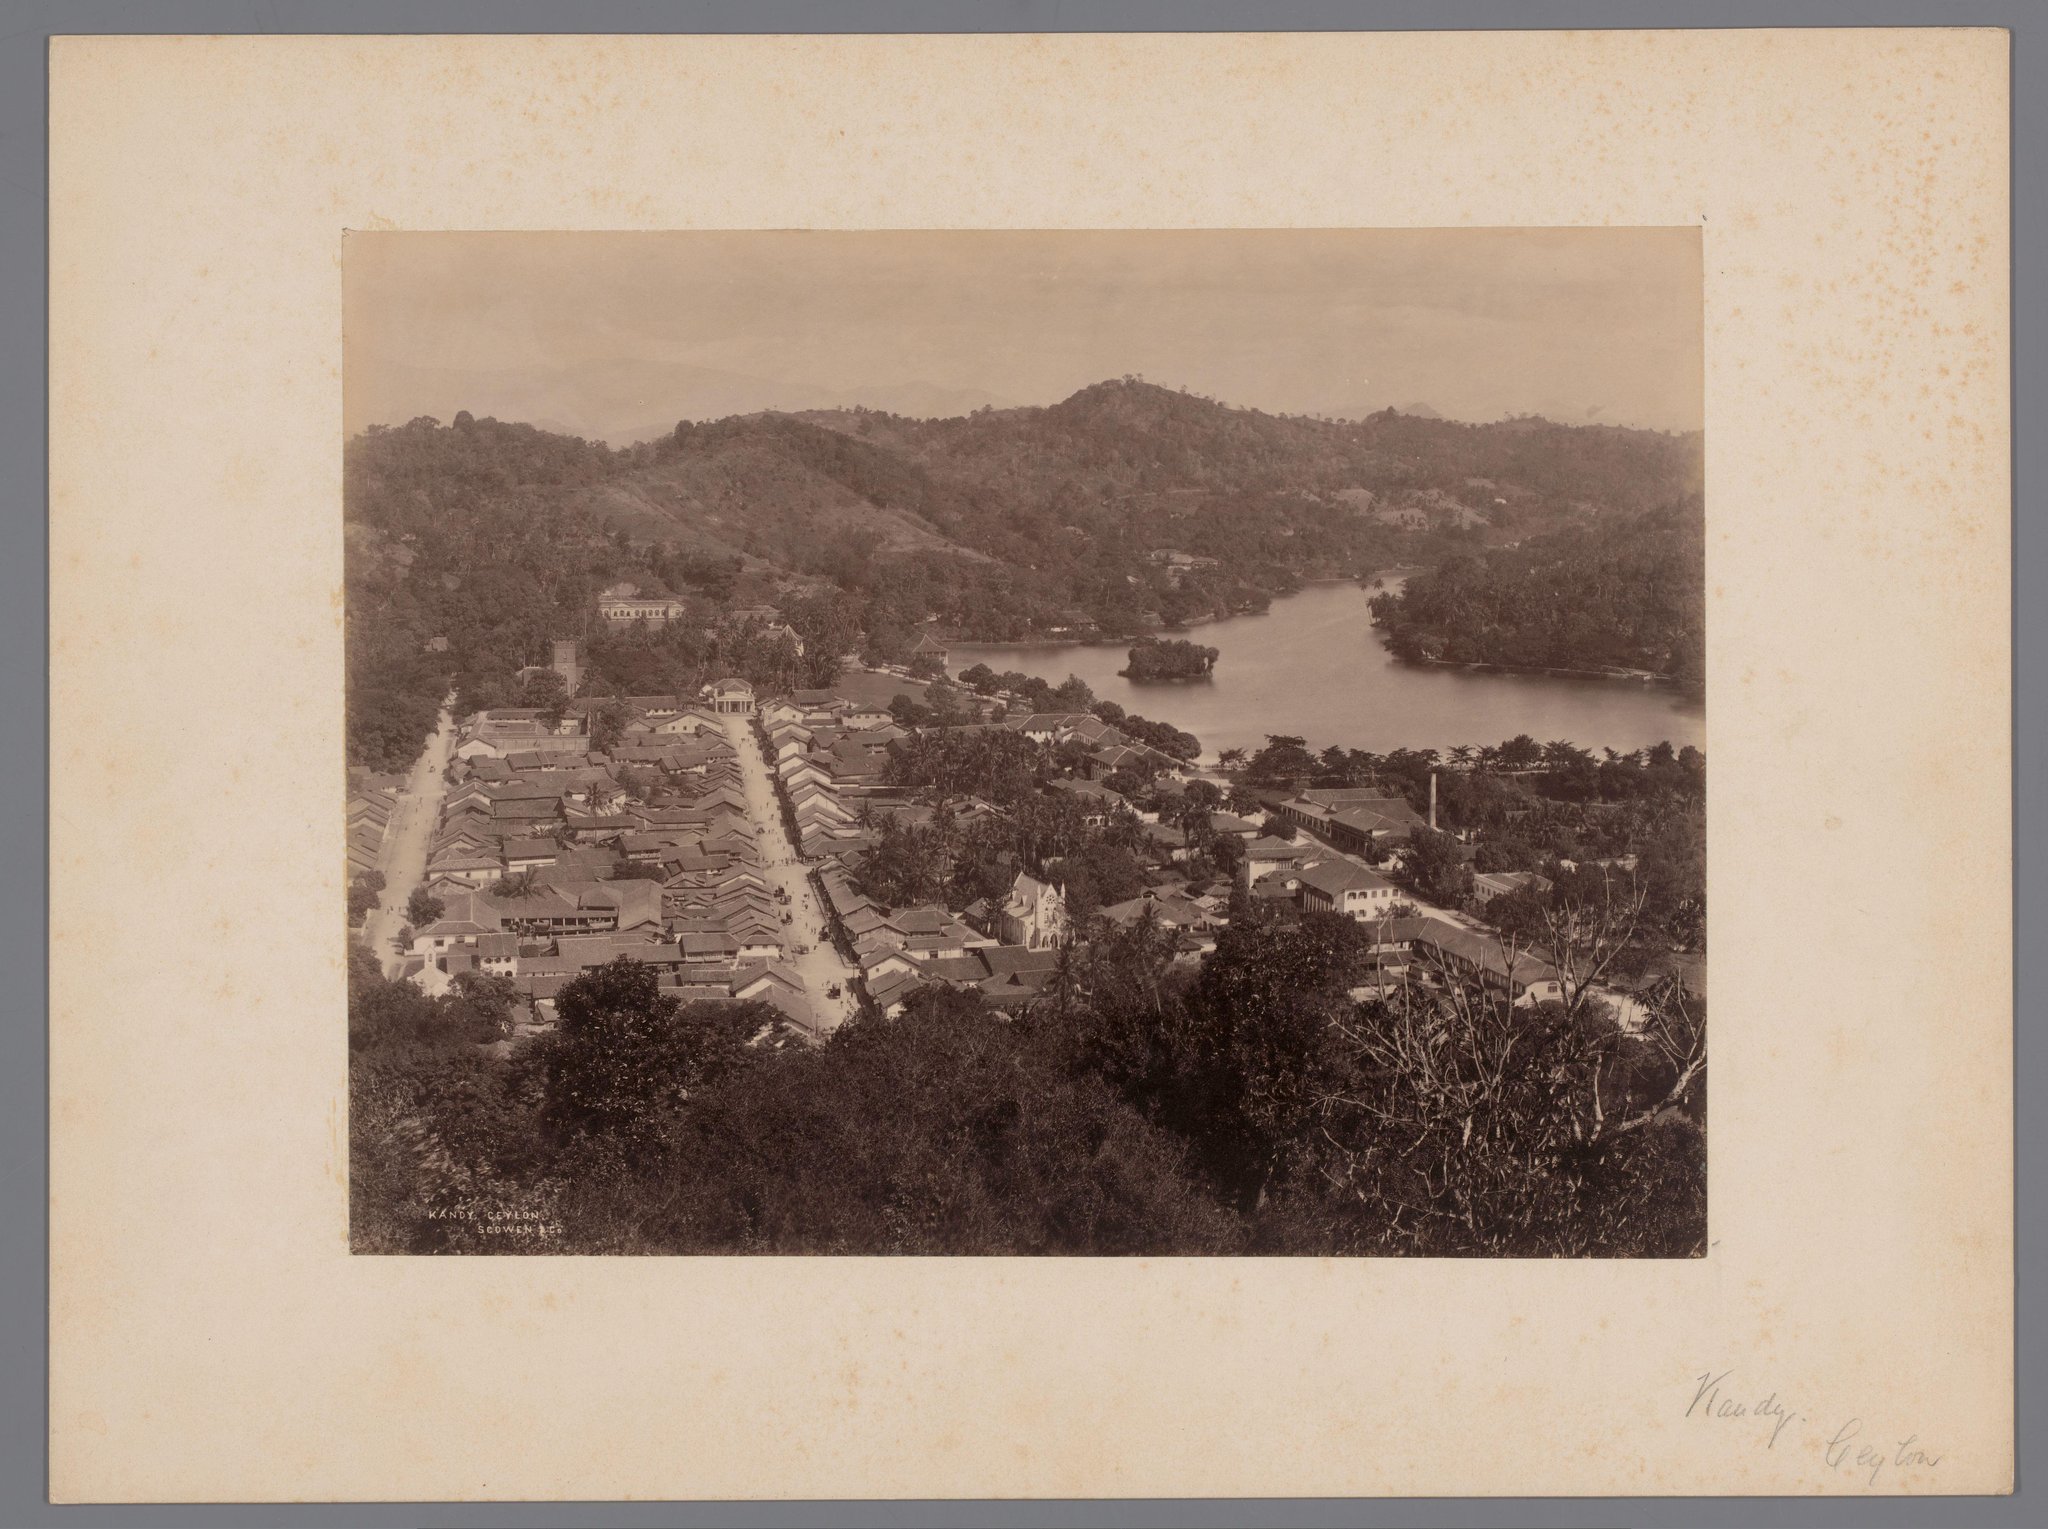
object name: photograph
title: View of Kandy, Sri Lanka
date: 1870-1890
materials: cardboard, paper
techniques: albumen print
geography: kandy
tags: sri lanka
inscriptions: inscription: ‘Kandy, Ceylon./ Scowen & Co.’, inscription: ‘Kandy/ Ceylon’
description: Gezicht over de stad Kandy in het gelijknamige district, Sri Lanka.